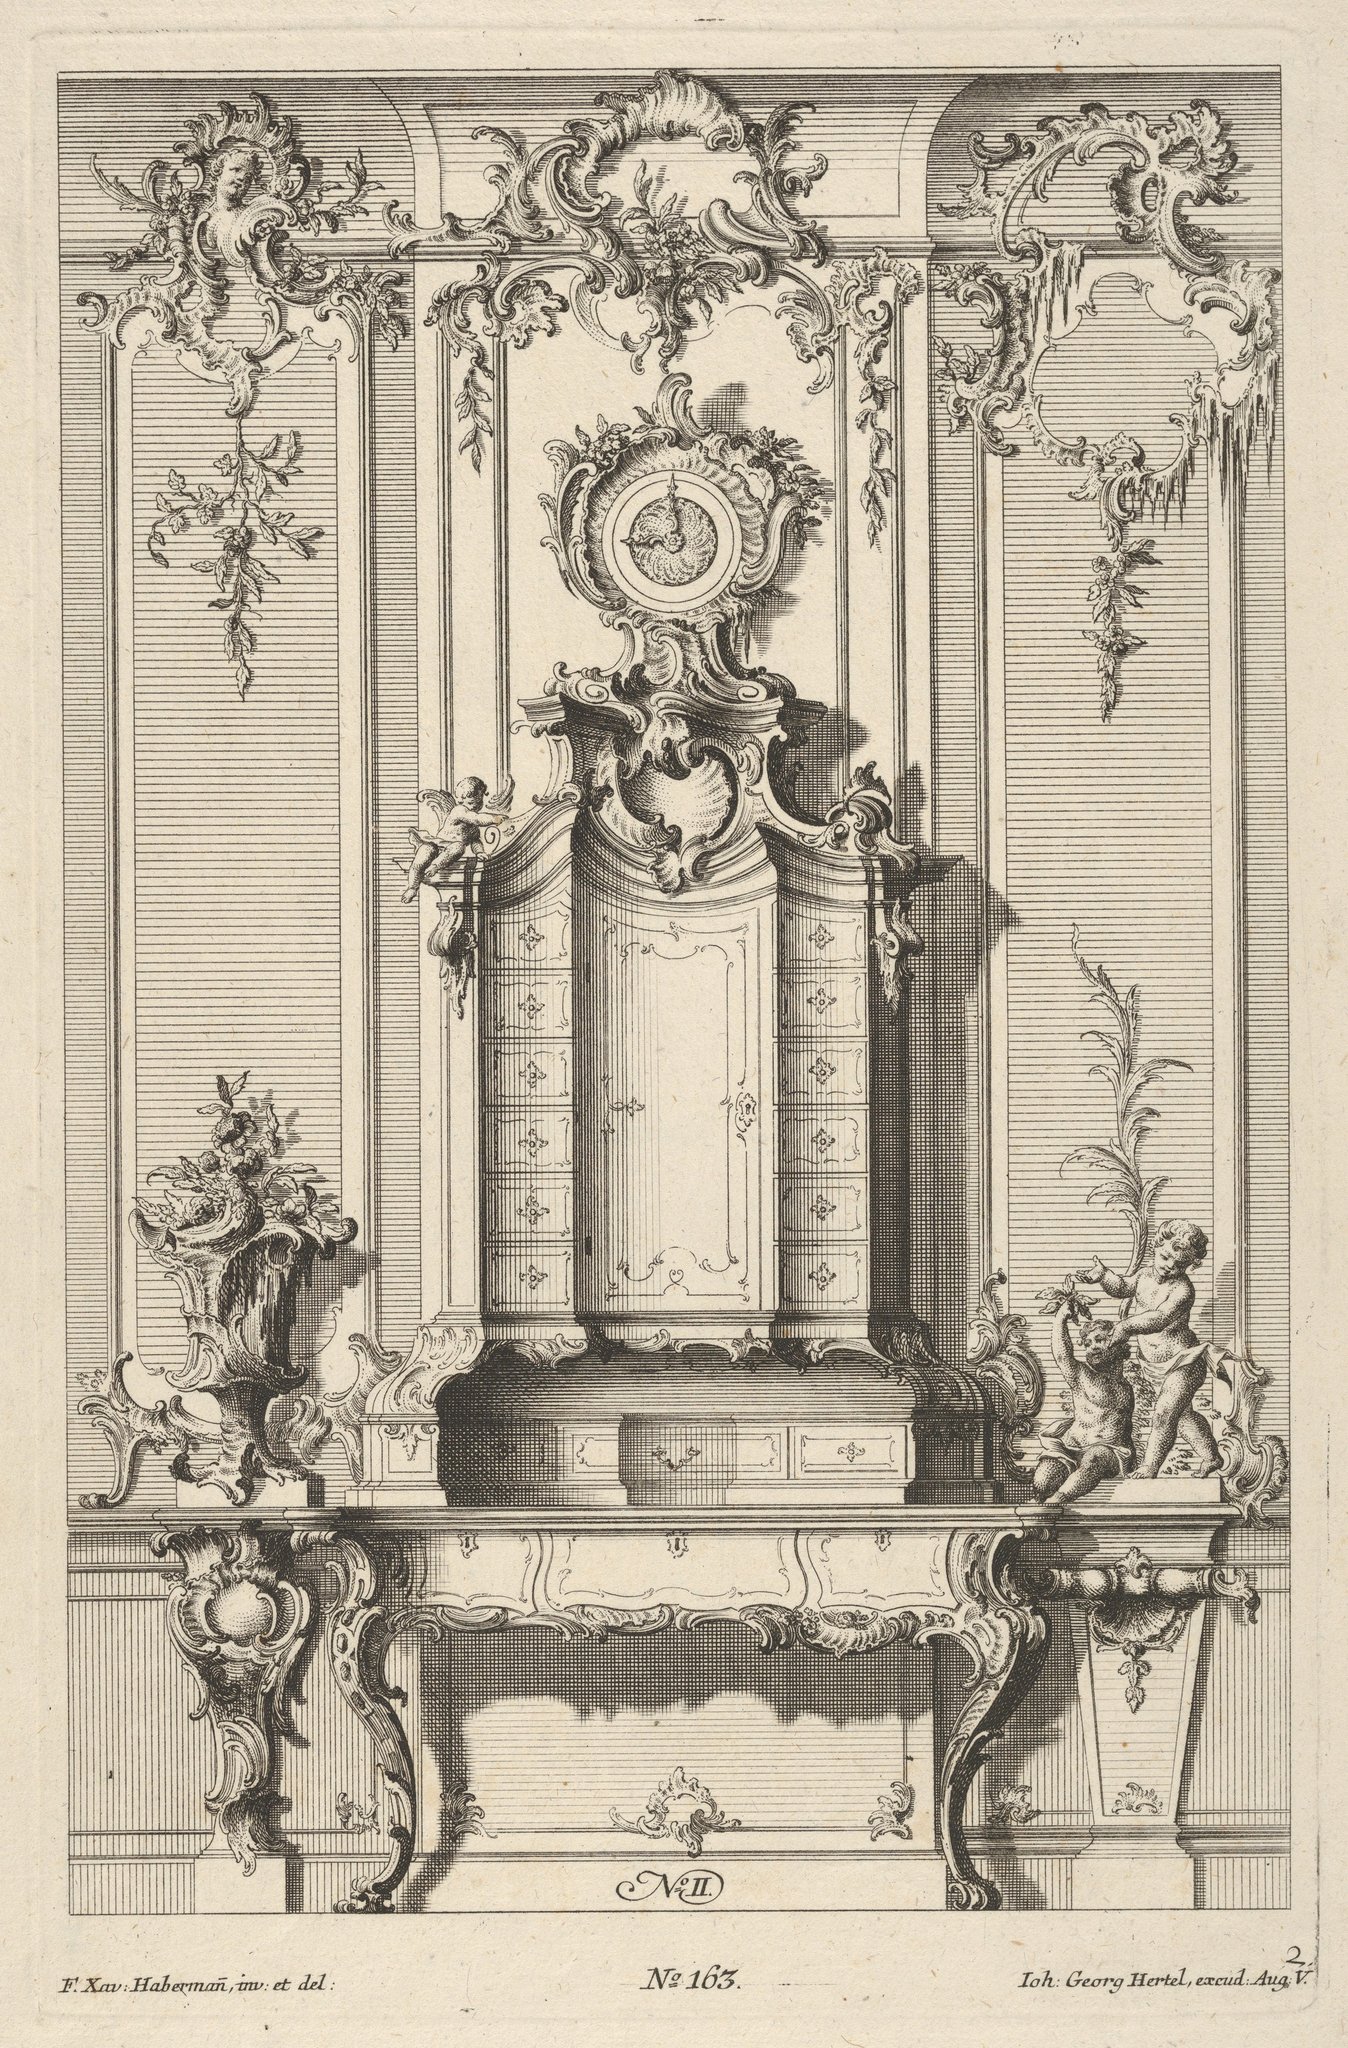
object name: print ornament architecture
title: Wall Elevation with a Secretaire, from 'Schreibtische'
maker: franz xavier habermann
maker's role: artist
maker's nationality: german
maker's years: 1721-1796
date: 1748-1770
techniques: etching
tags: ornament,putti,clocks,desks